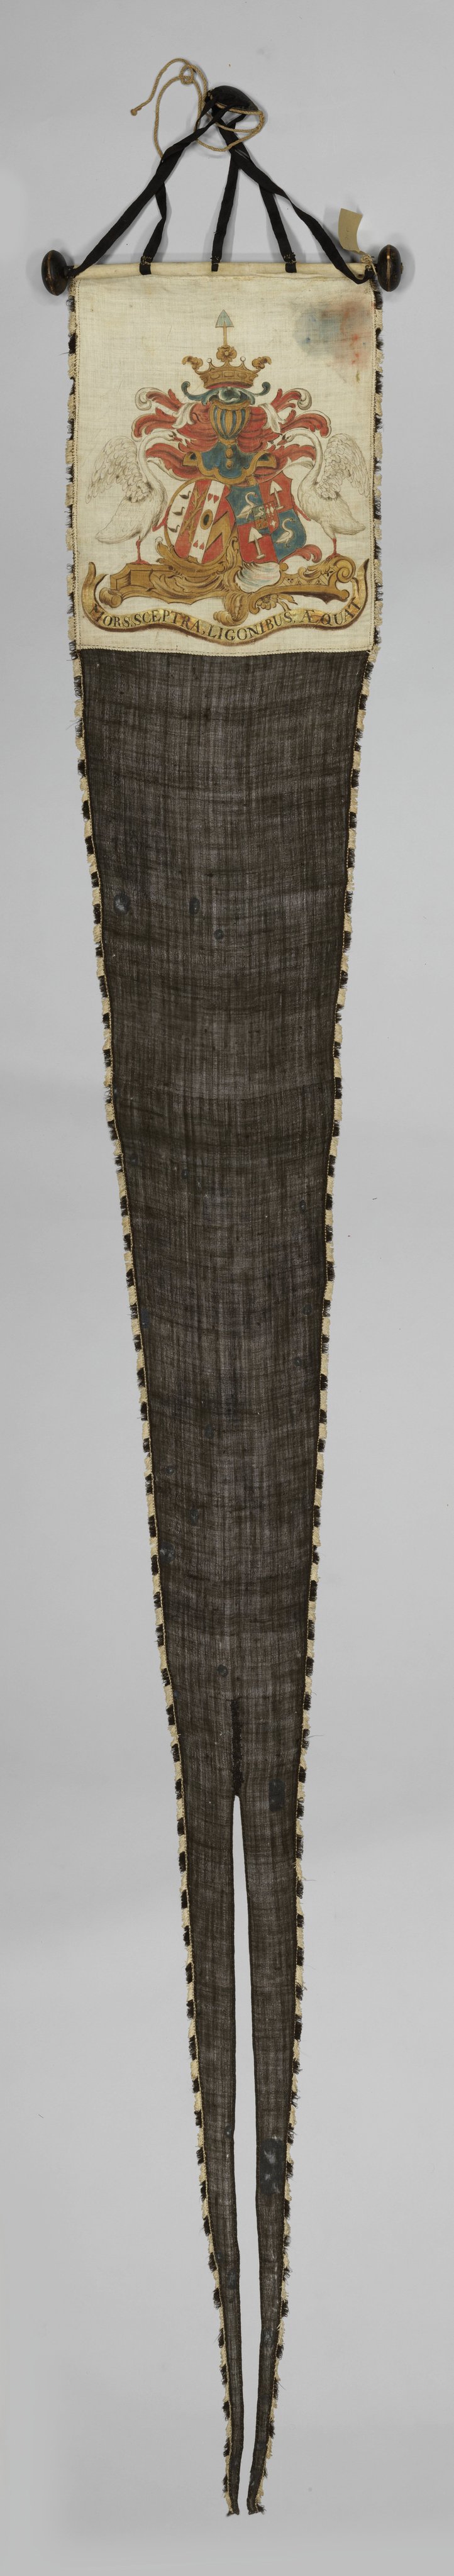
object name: rouwwimpel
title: Rouwwimpel aan zwarte stok met knoppen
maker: Anonymous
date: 1767-1798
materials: linen, paint, wool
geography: netherlands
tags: gerrit de graeff, christina van herzeele, noord-holland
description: Zwarte wimpel met korte zwart-witte franje. Aan broekzijde een witte rechthoek, met de wapens van Gerrit de Graeff en Christina van Herzeele, tezamengebracht onder een helm in blauw met oker tegen rood lofwerk. Hierboven een kroon met vijf punten: drie met fleurons, twee met parels, afwisselend, en boven de middelste een rechtopstaande troffel met okerkleurige steel en blauwe schep. Terweerszijden van de wapens een zwaan die zijn kop in het rode lofwerk steekt. Dit alles staat op een asymetrische voet met lofwerk. Hieronder een banderol in goud, waarop in zwarte klassieke kapitalen: MORS, SCEPTRA, LIGONIBUS, AEQUAT. Vlucht gespleten.